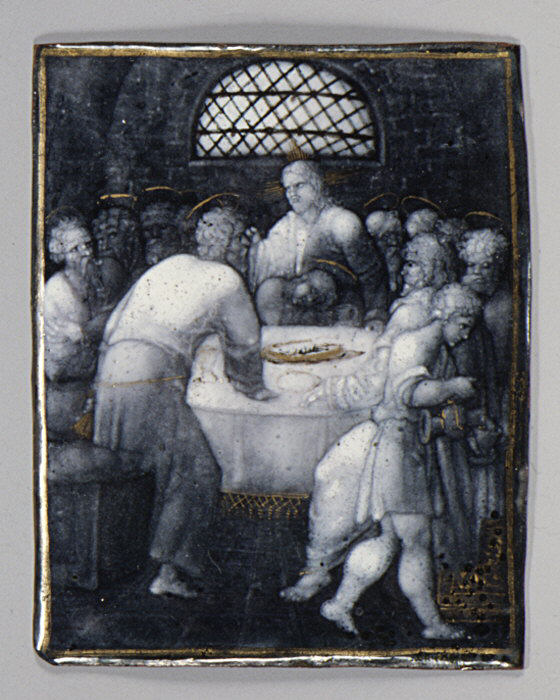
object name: plaque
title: The Last Supper (one of seven)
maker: jean ii pénicaud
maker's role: enameler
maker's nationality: french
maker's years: 1524-1554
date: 1534-1566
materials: copper, enamel, gilt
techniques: painting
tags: jesus,last supper